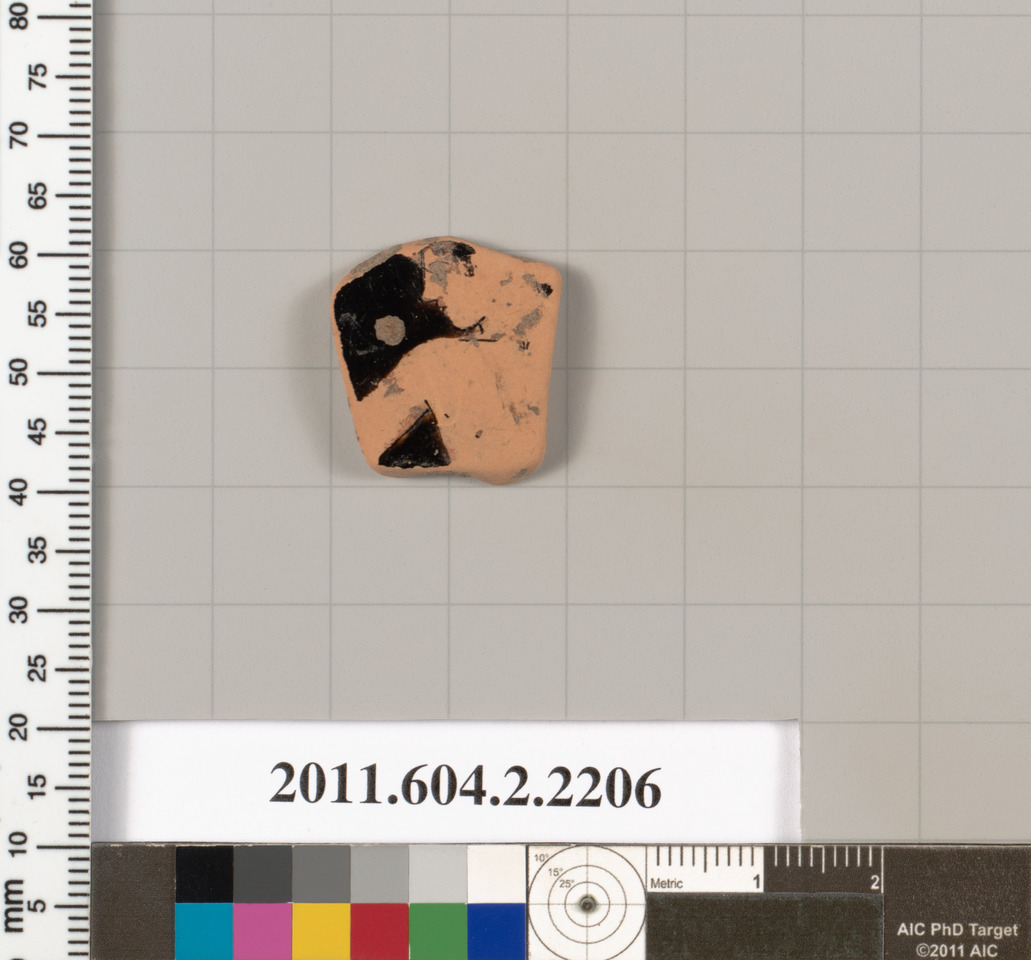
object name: pot fragment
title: Terracotta fragment of a pot; unglazed on the inside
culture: greek, attic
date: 490-470 BCE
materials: terracotta